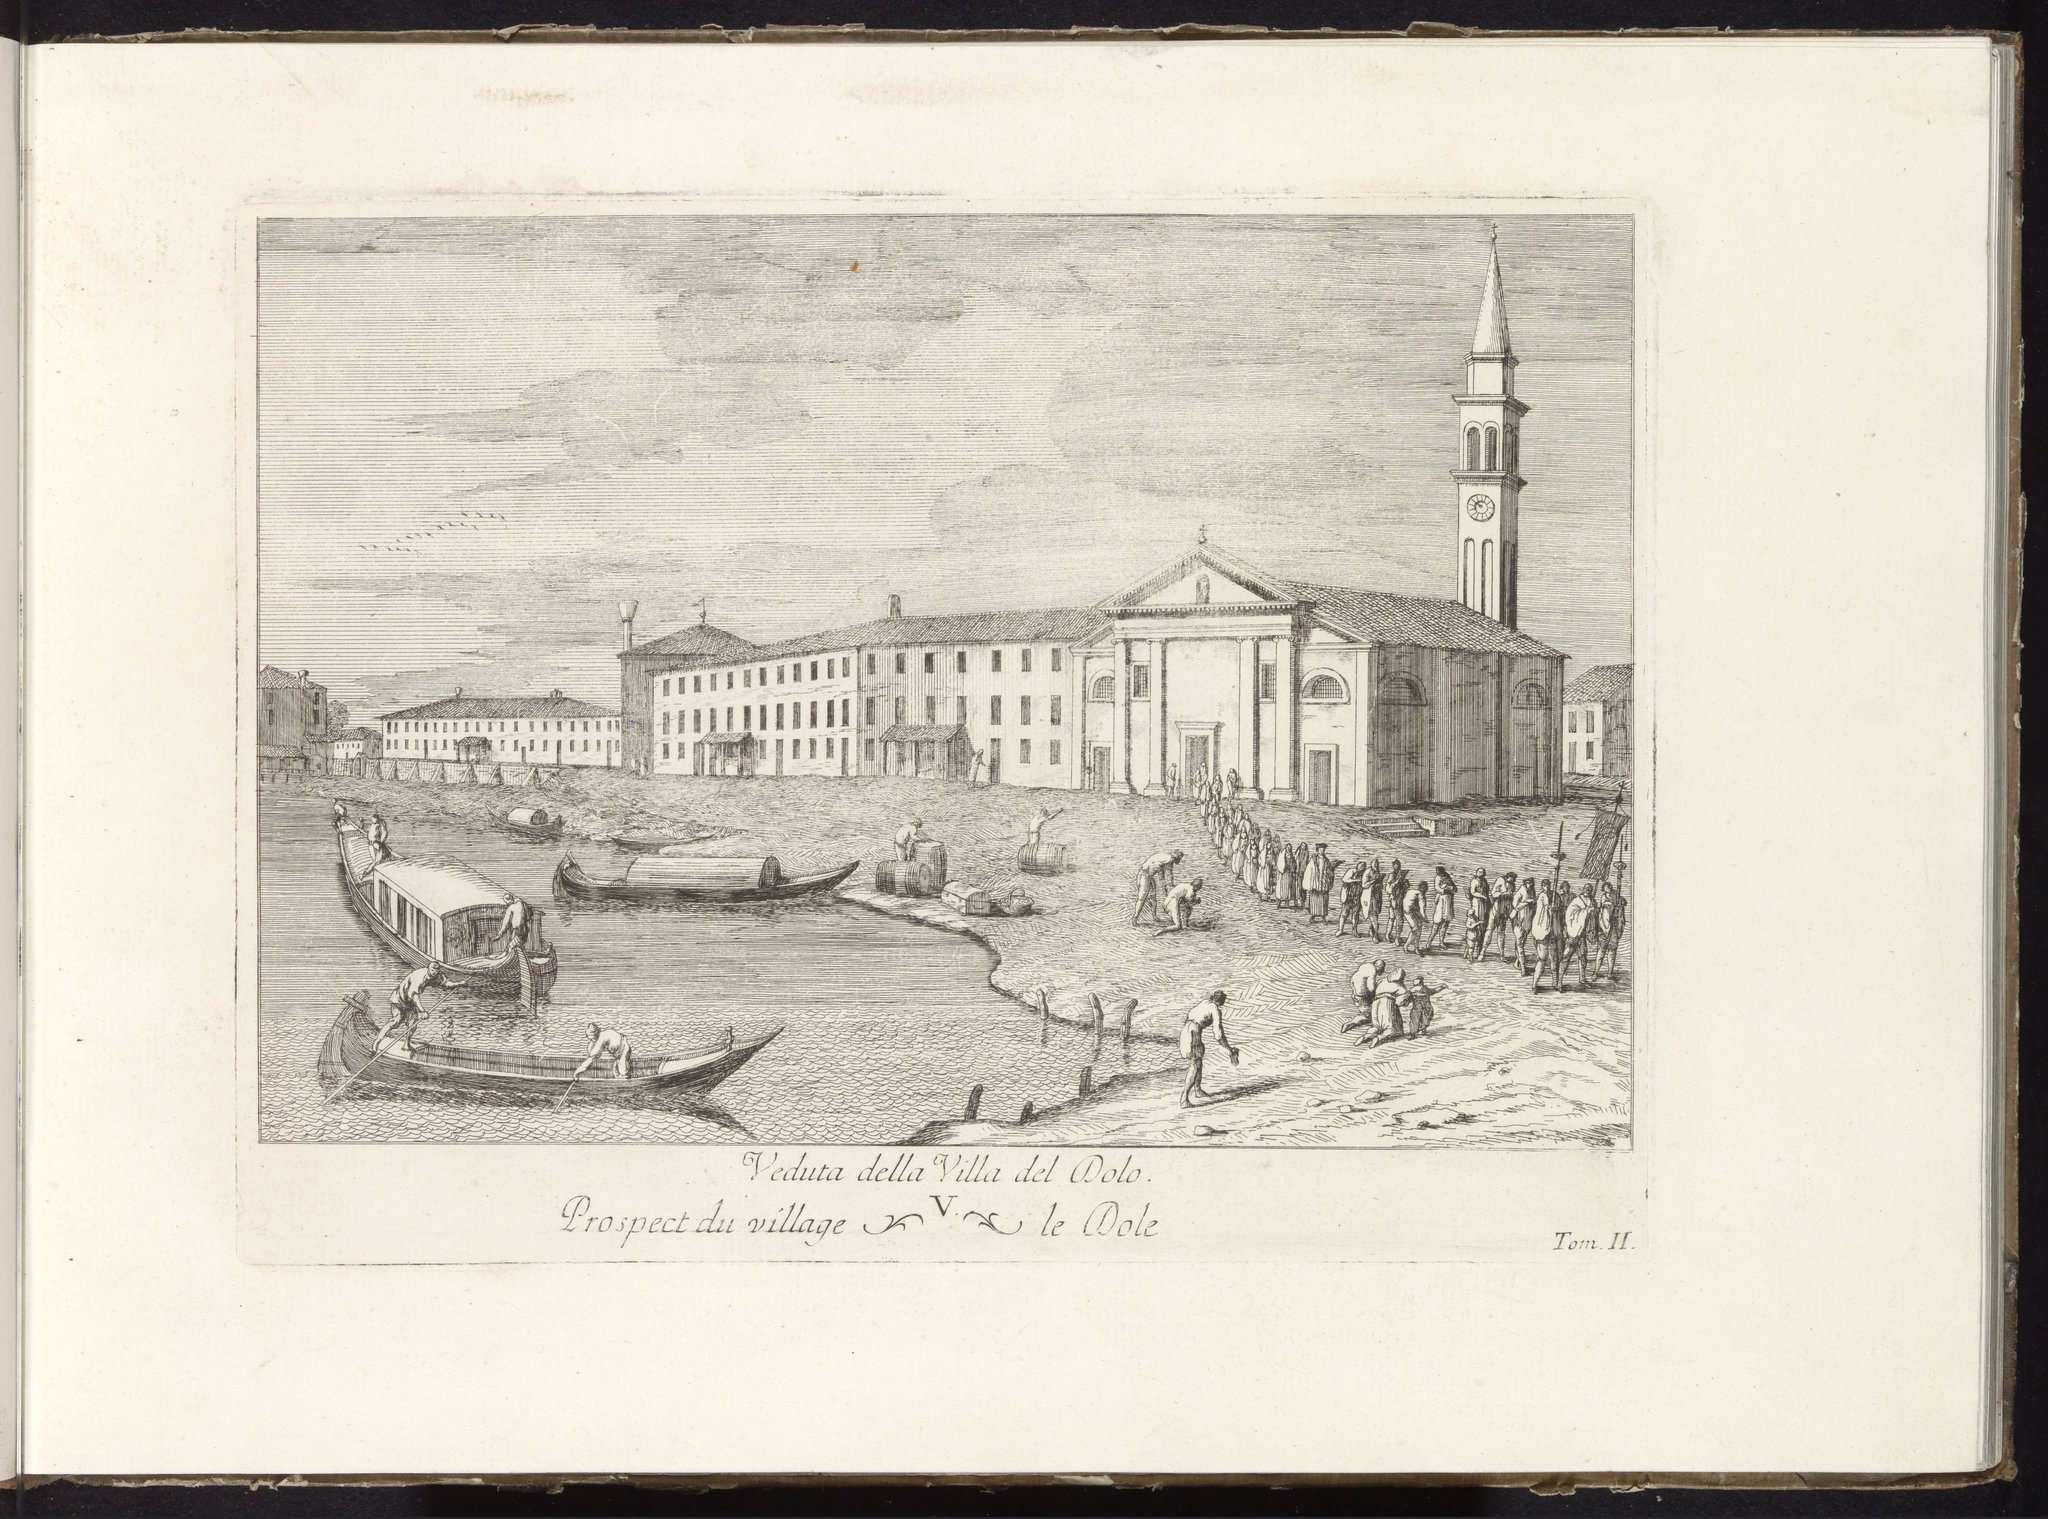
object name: print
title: Les delices de la Brenta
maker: giovanni francesco costa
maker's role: draughtsman, painter, print maker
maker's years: -1773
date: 1750-1760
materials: paper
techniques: etching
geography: venice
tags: river, procession ~ christian religion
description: Gezicht op het dorp Dolo aan de rivier de Brenta. Vanuit de kerk komt een processie van gelovigen naar buiten. Genummerd midden onder: V en rechtsonder: Tom: II. Deze prent maakt deel uit van een album.